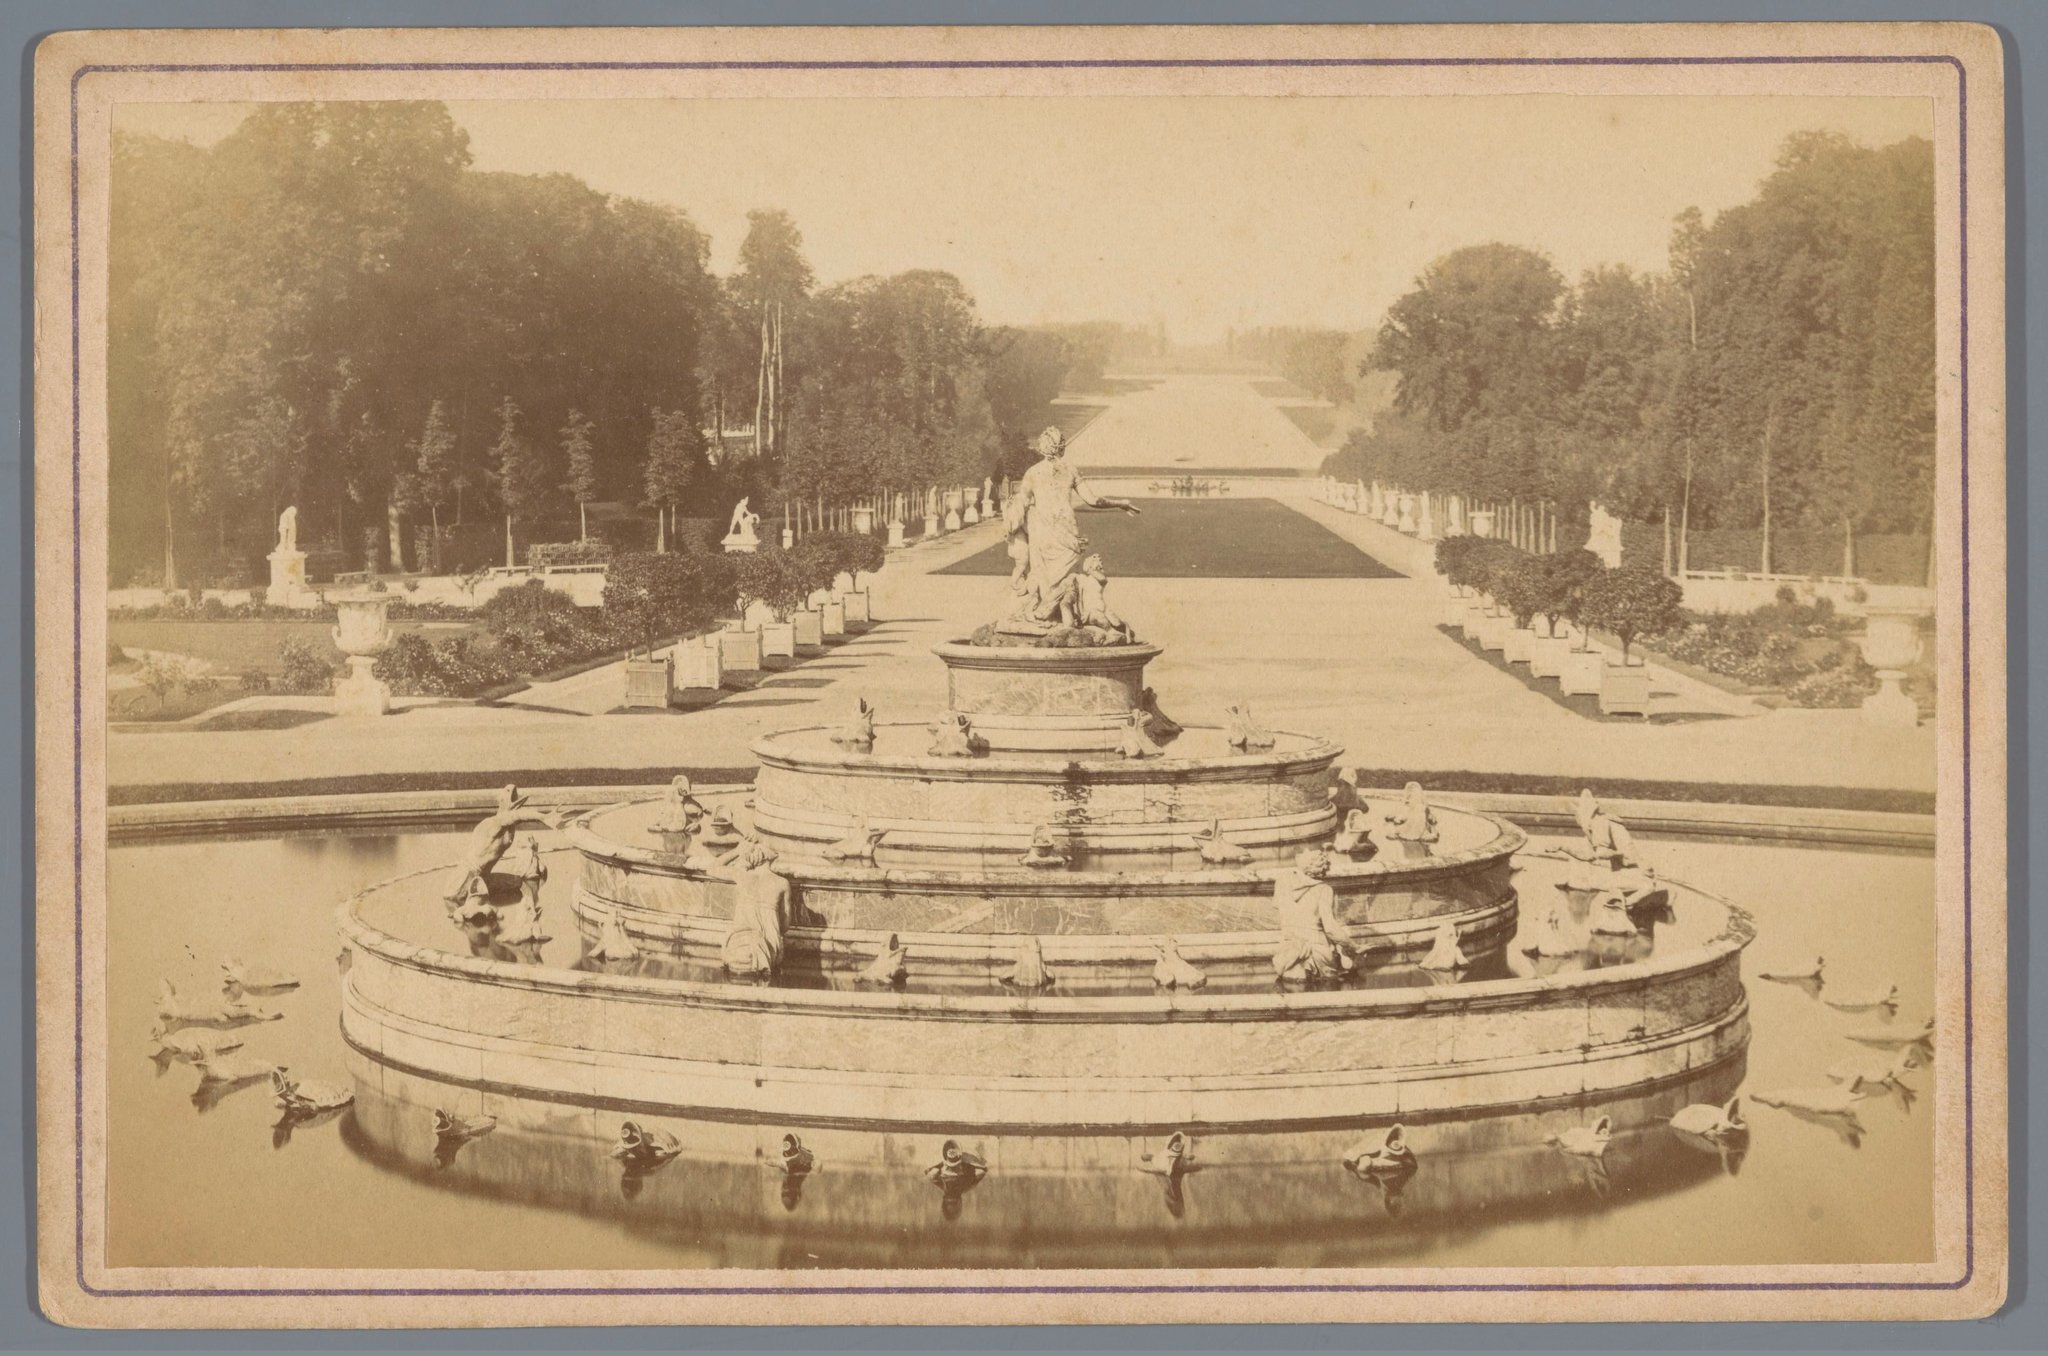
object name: cabinet photograph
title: Latonavijver in de Tuin van Versailles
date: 1865-1875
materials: cardboard, photographic support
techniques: albumen print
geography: gardens of versailles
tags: ornamental fountain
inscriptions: inscription: ‘Compagnie Photographique Debitte & Hervé 170, Rue de Rivoli, Paris’